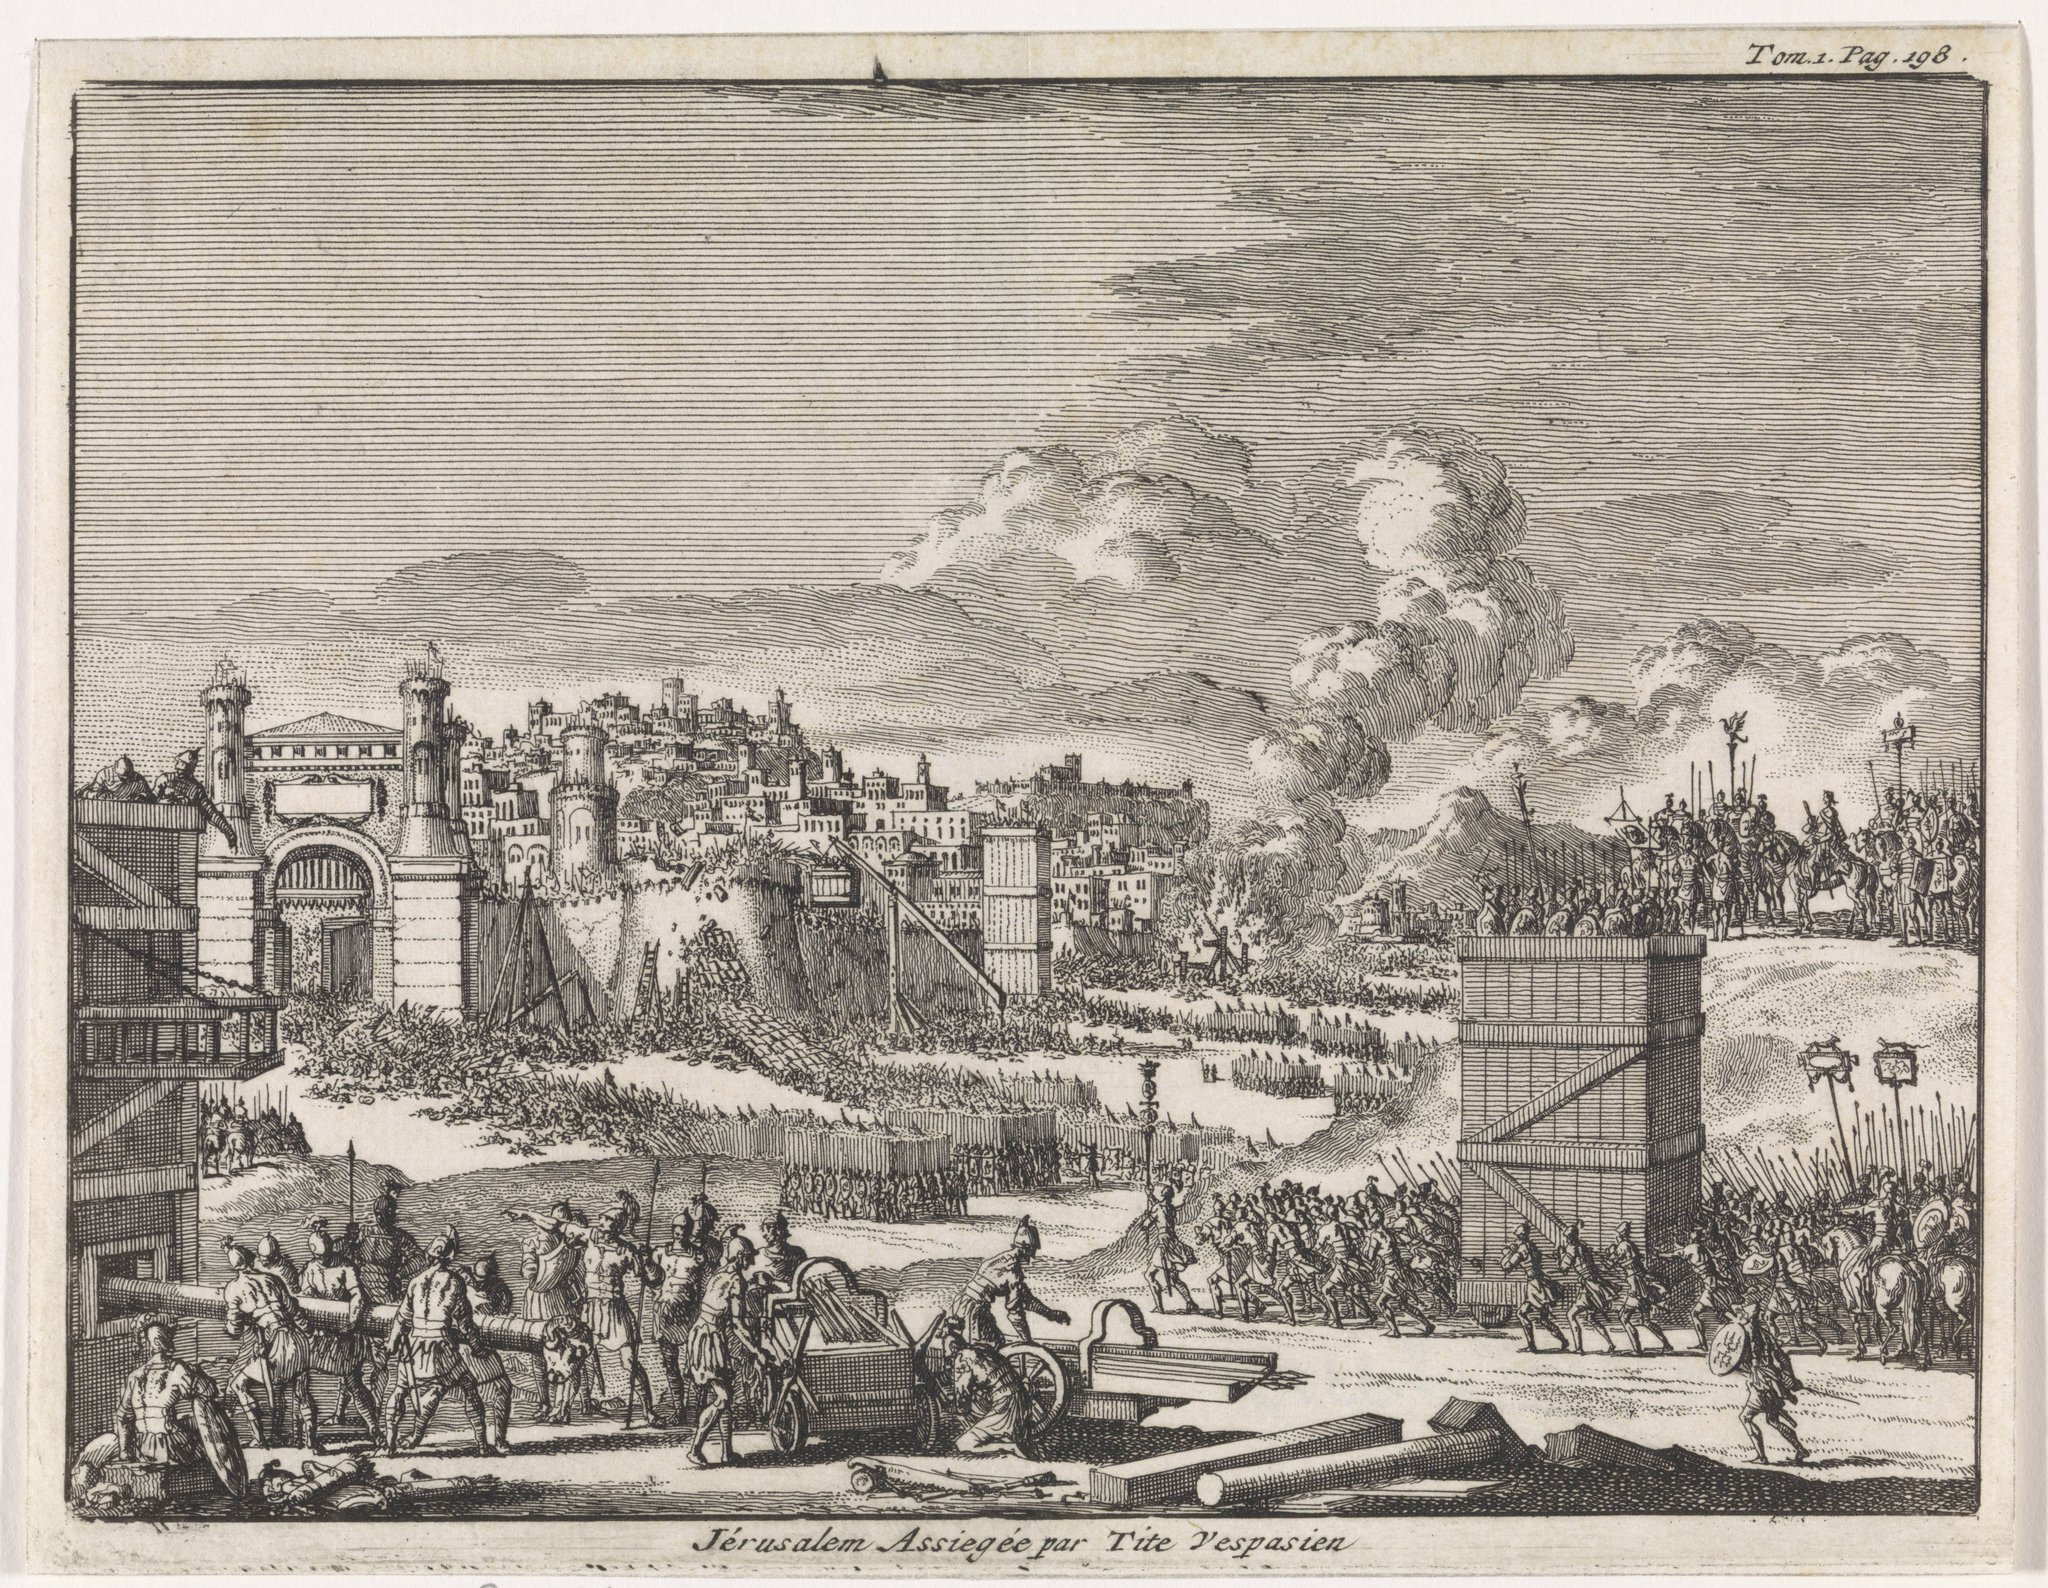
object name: book illustration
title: Jérusalem Assiegée par Tite Vespasien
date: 1705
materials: paper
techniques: etching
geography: amsterdam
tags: breaking into city or fortress ~ siege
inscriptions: collector's mark: Lugt 2228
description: Illustratie uit: Cunaeus, Petrus. La republique des Hebreux, 3 delen. Amsterdam: Pieter Mortier, 1705, dl. I, p. 198.